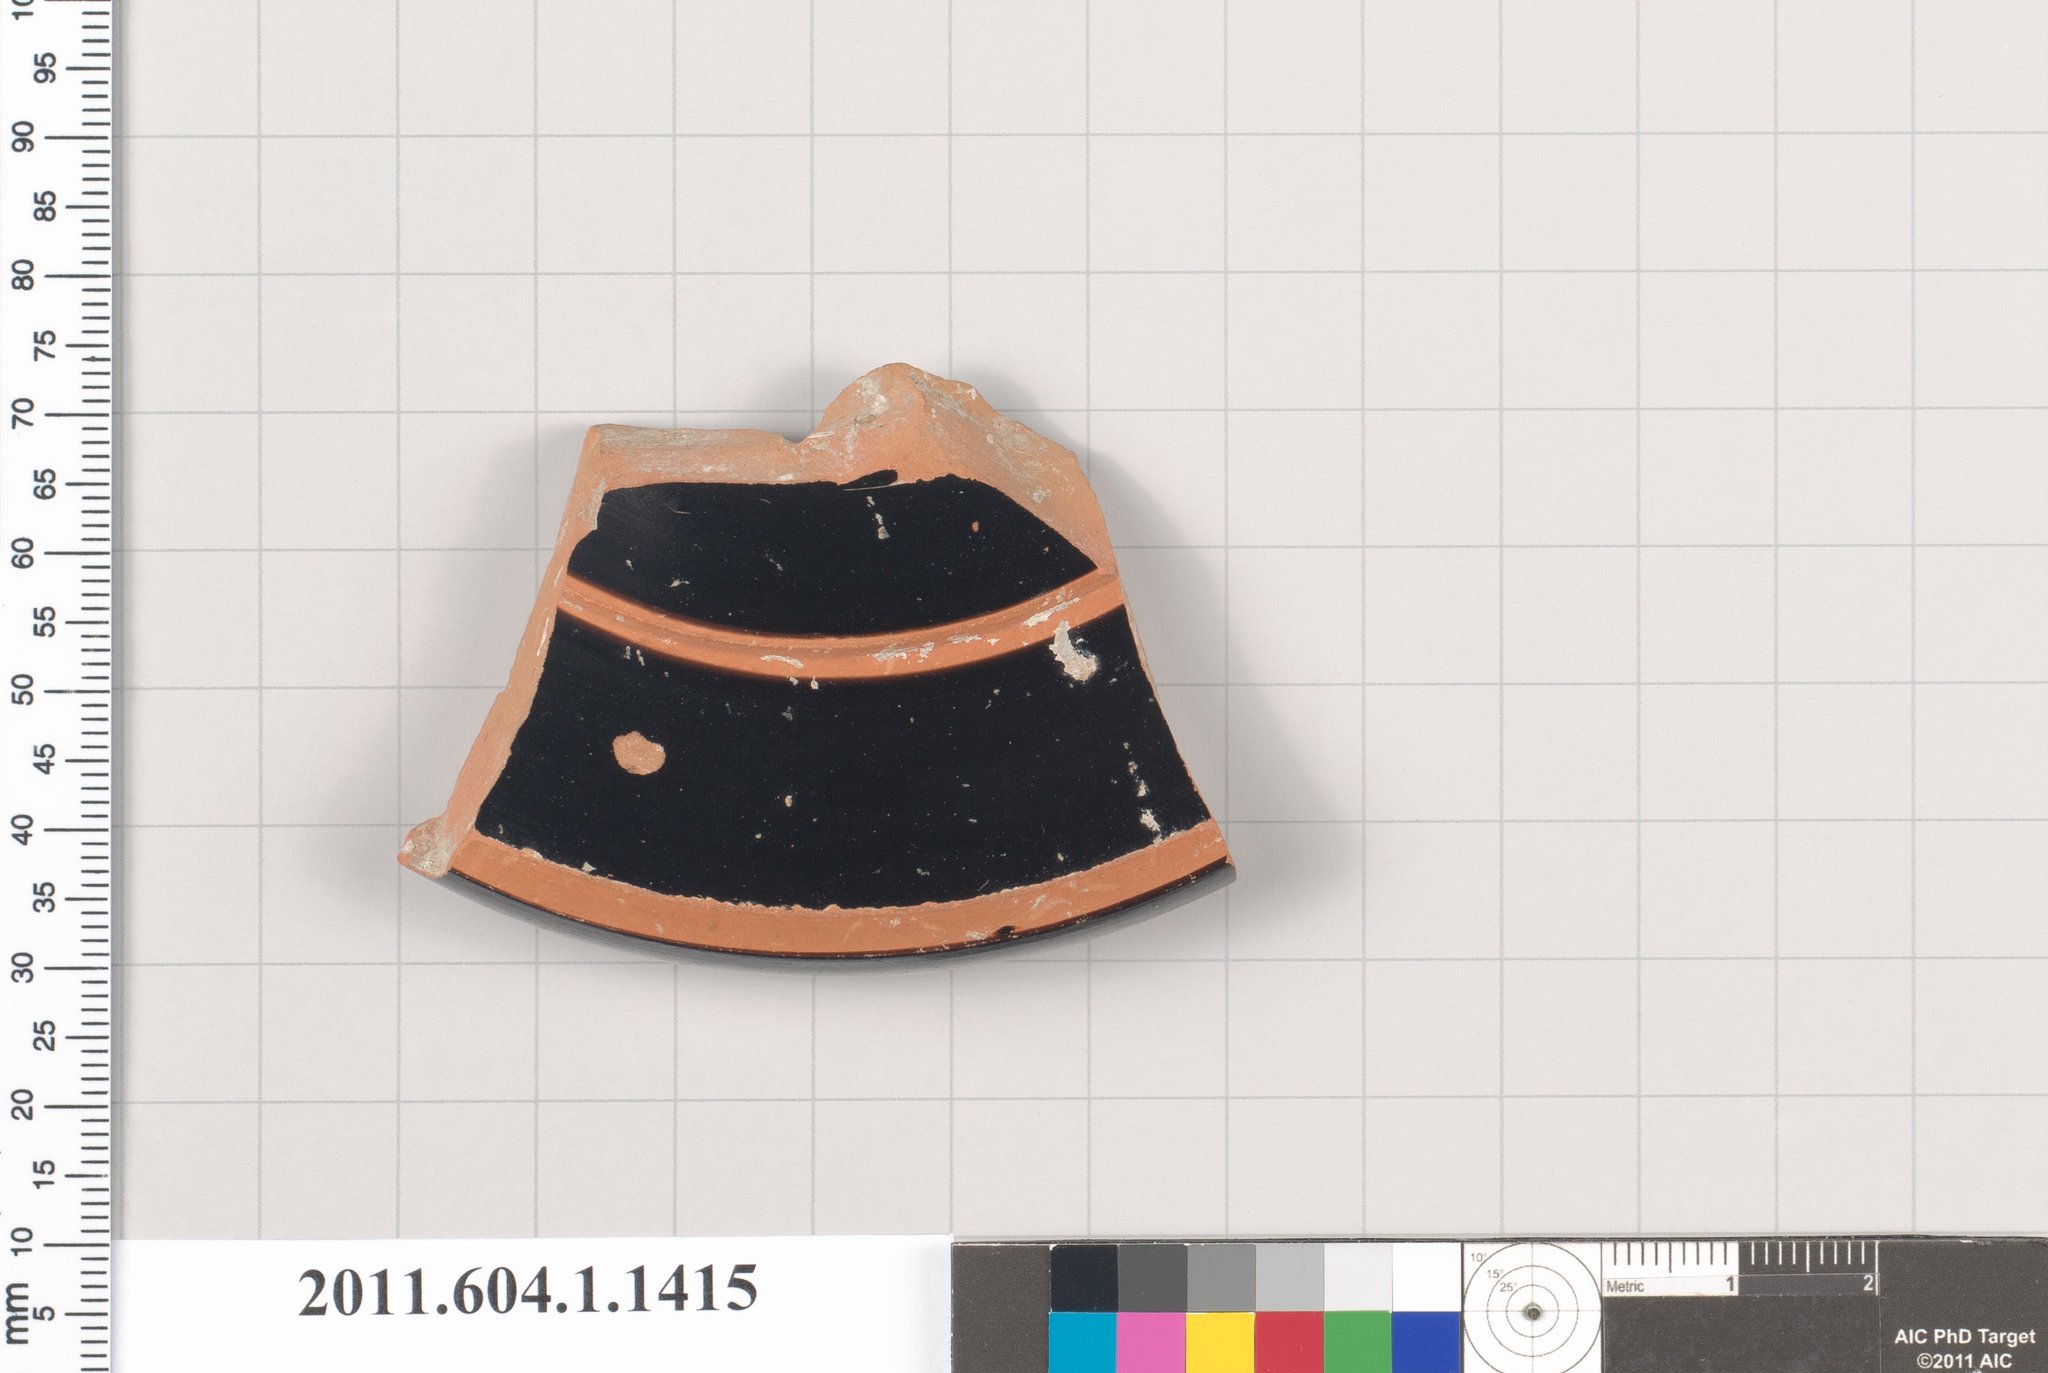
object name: kylix fragment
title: Terracotta fragment of a kylix (drinking cup)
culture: greek, attic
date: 500-401 BCE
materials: terracotta